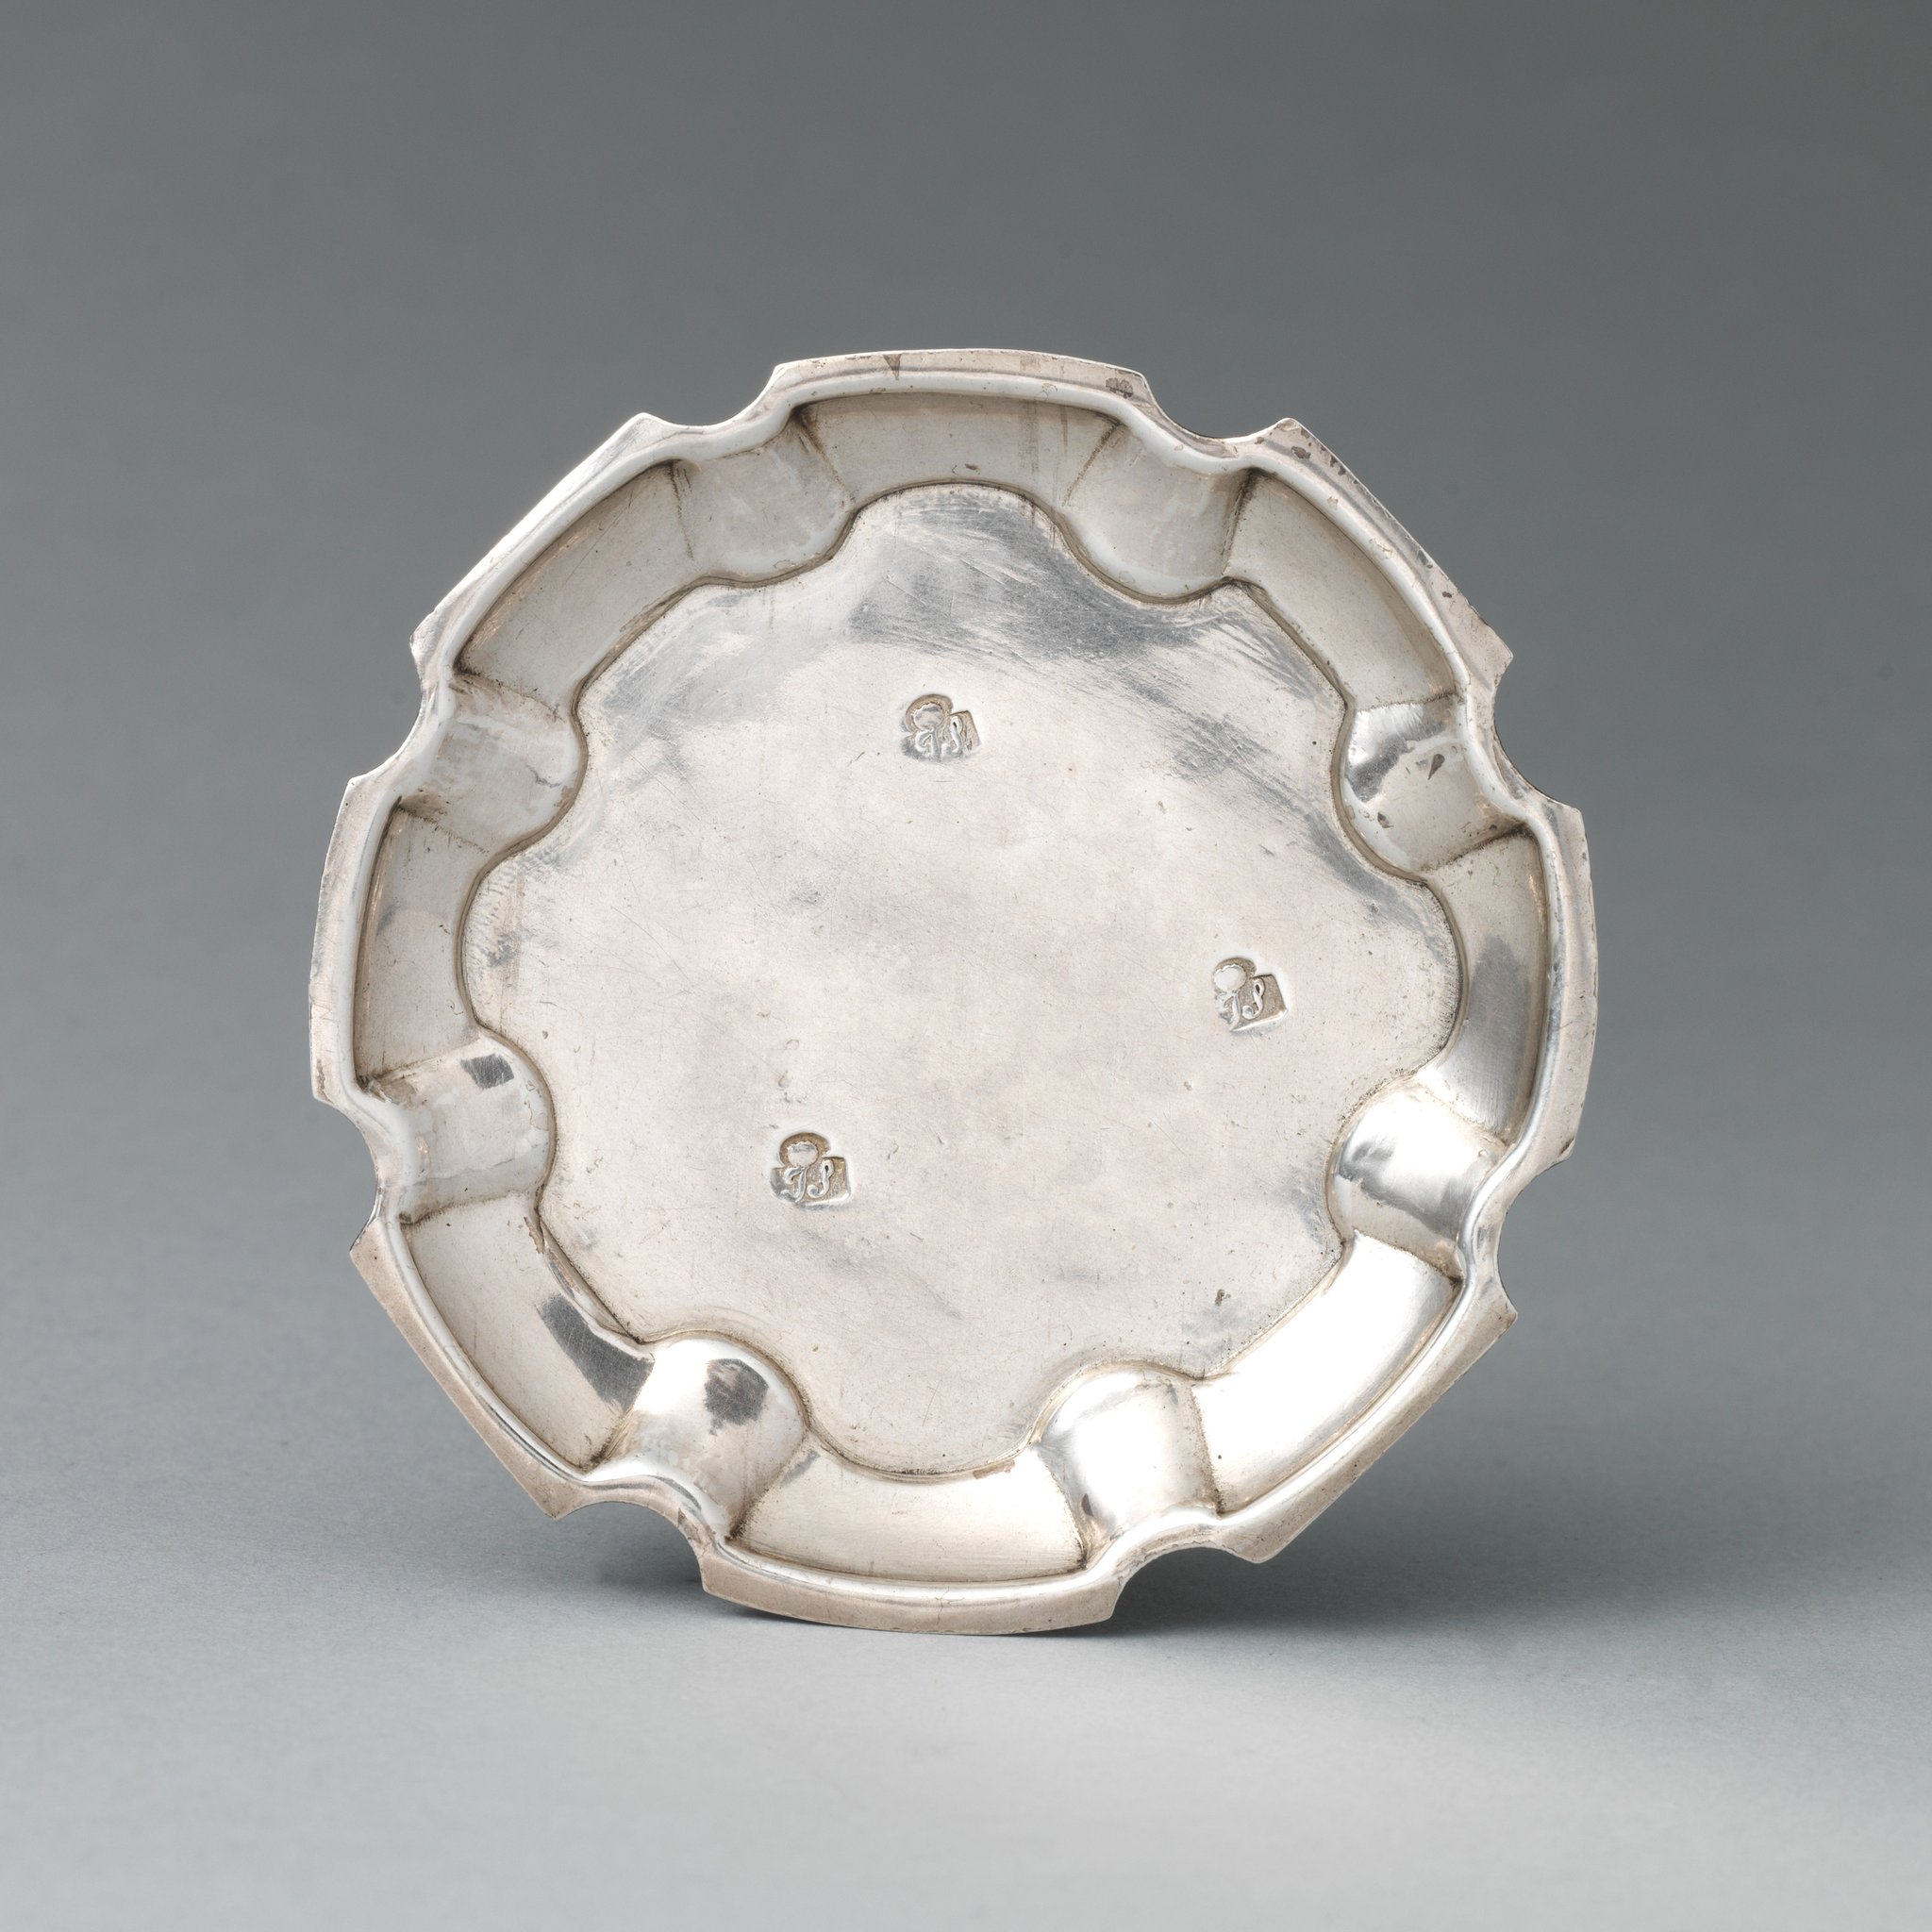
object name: waiter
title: Miniature waiter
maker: john le sage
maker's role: maker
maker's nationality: british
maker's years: 1718-1743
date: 1740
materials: silver